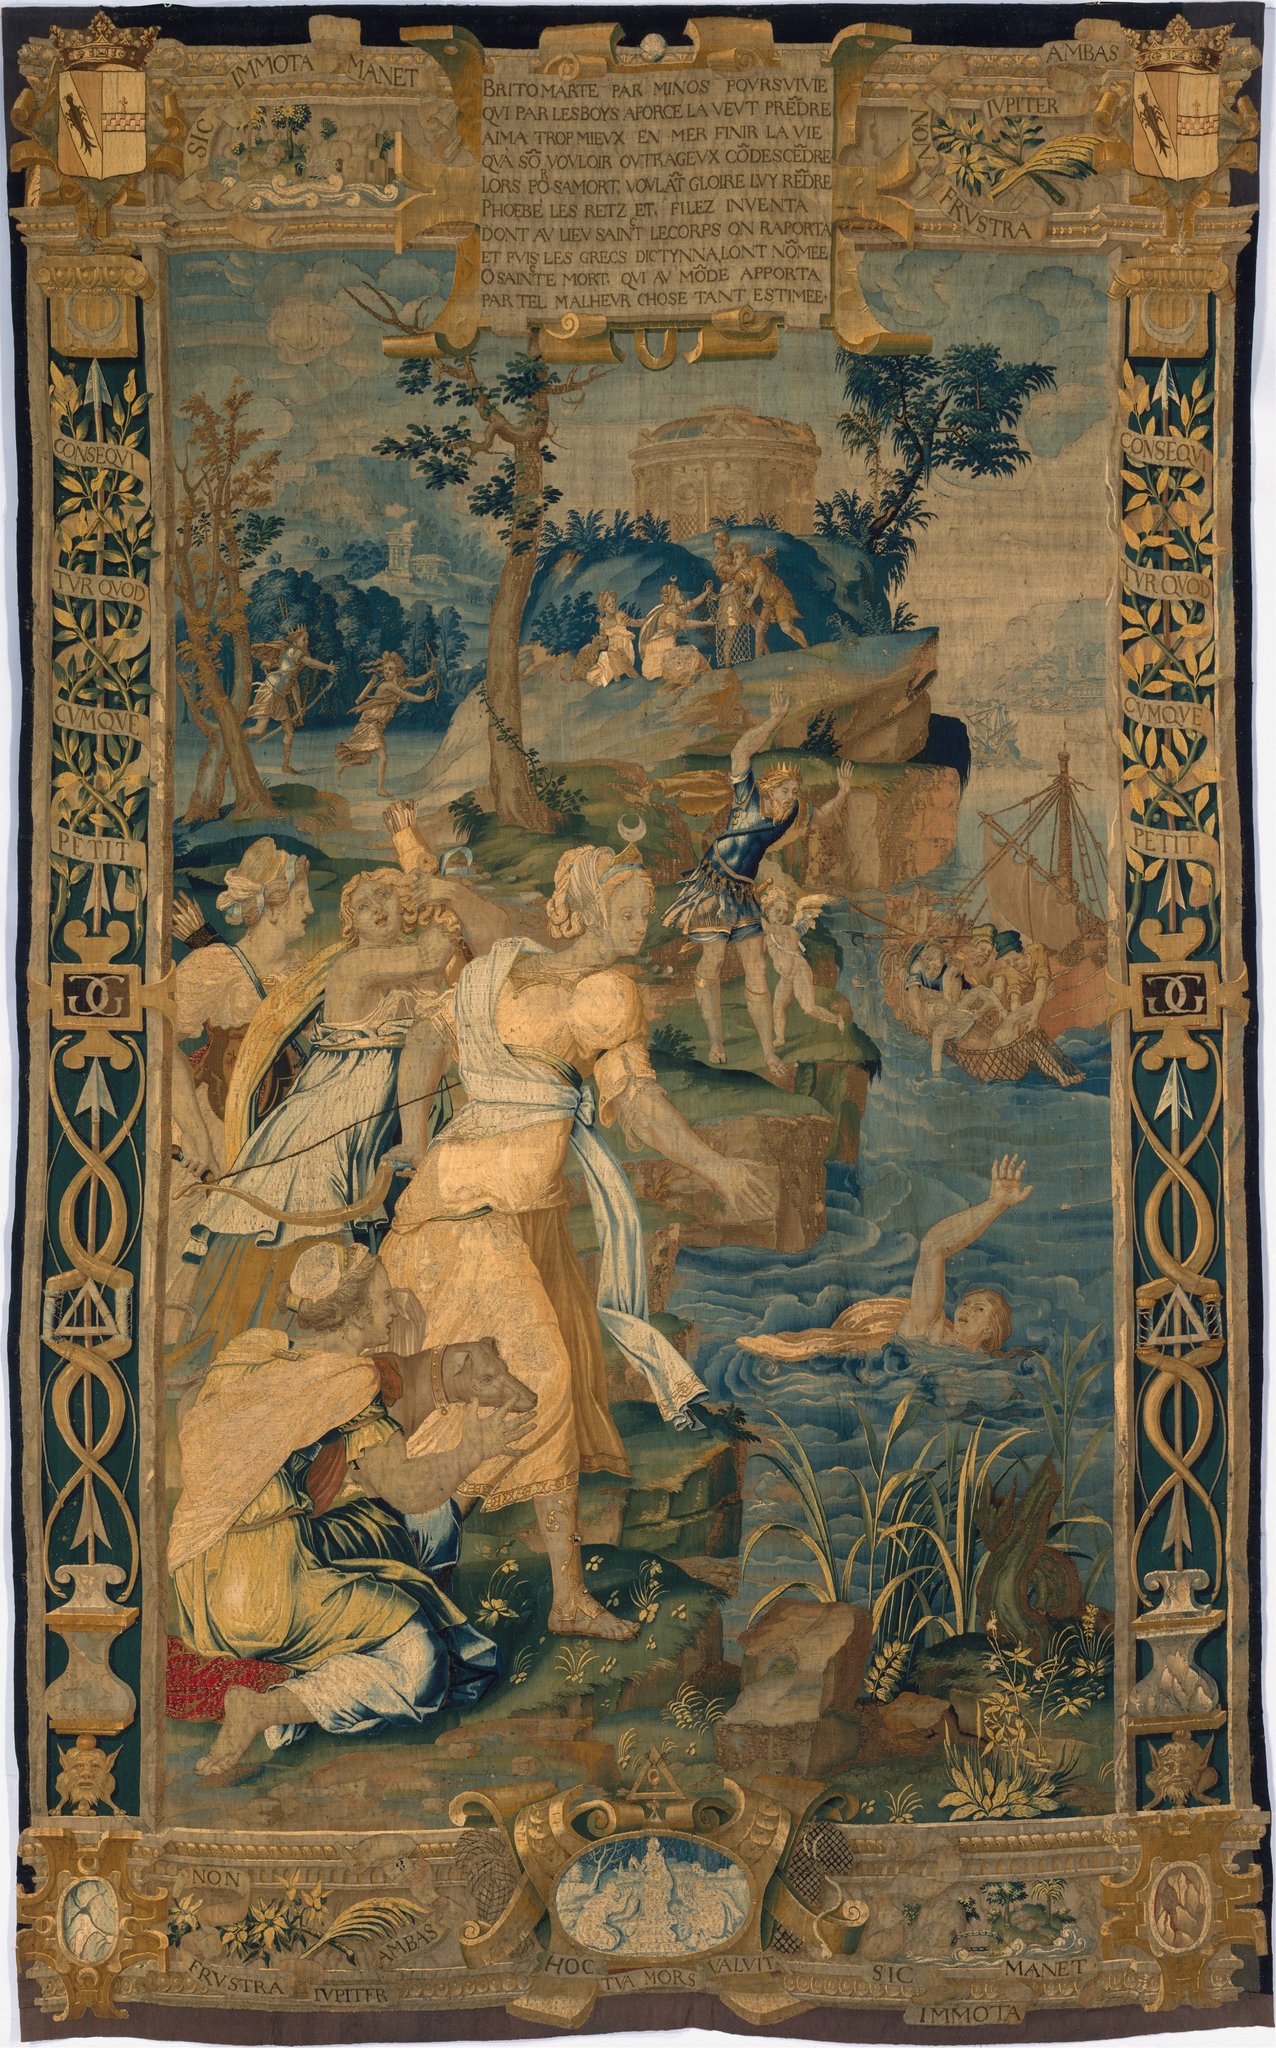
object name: tapestry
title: The Drowning of Britomartis from Scenes from the Story of Diana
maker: jean cousin the elder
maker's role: designer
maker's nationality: french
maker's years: 1485-1565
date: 1547-1559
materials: silk, wool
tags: men,diana,coat of arms,boats